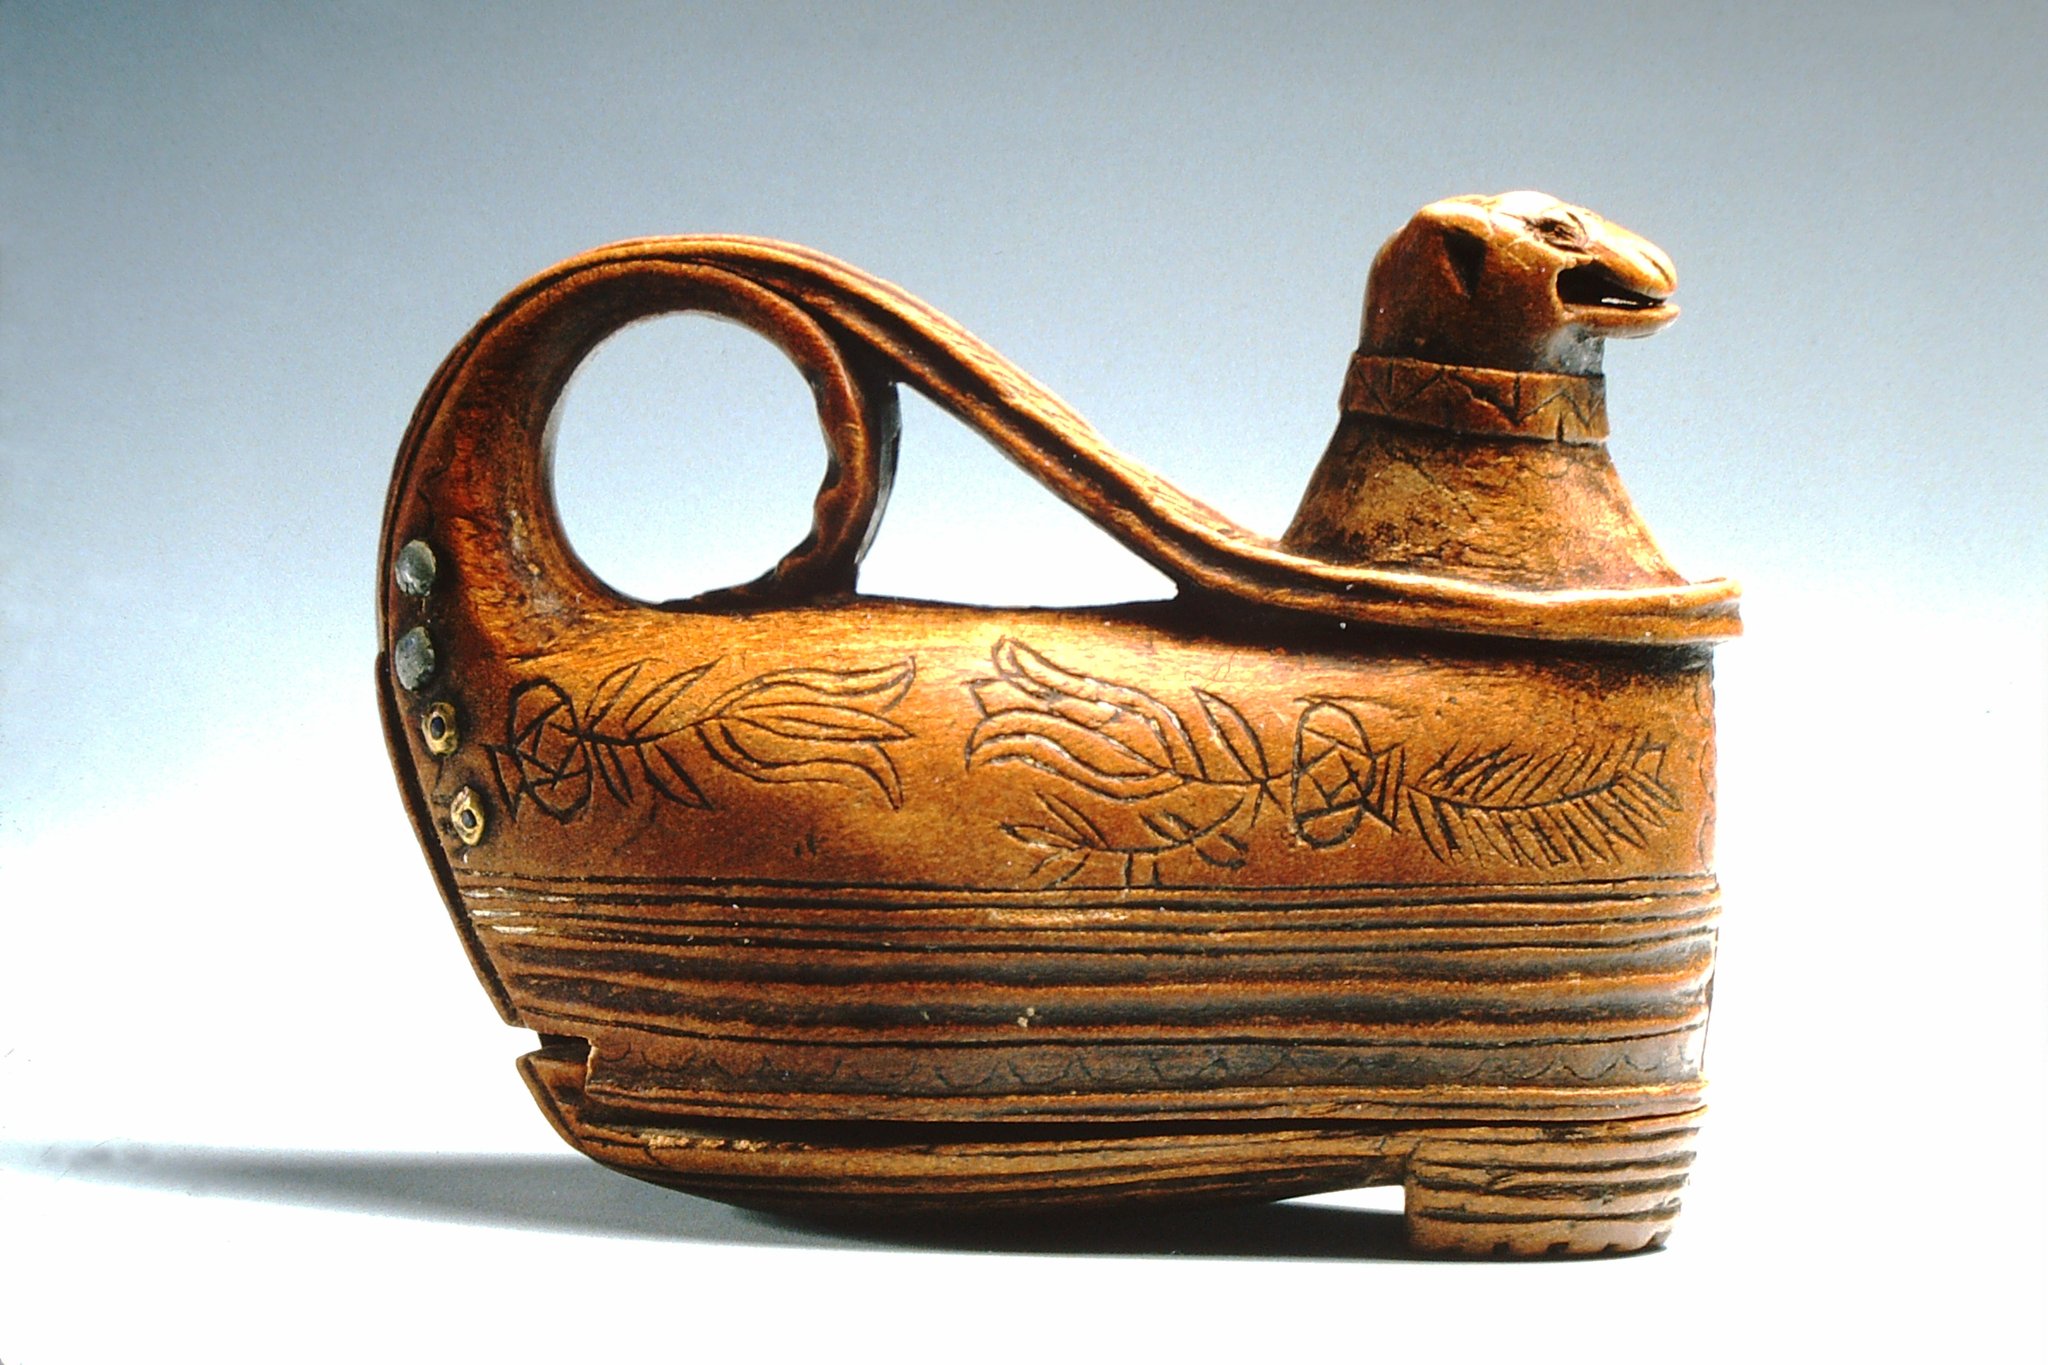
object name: jew's harp container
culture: european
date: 1601-1900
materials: wood